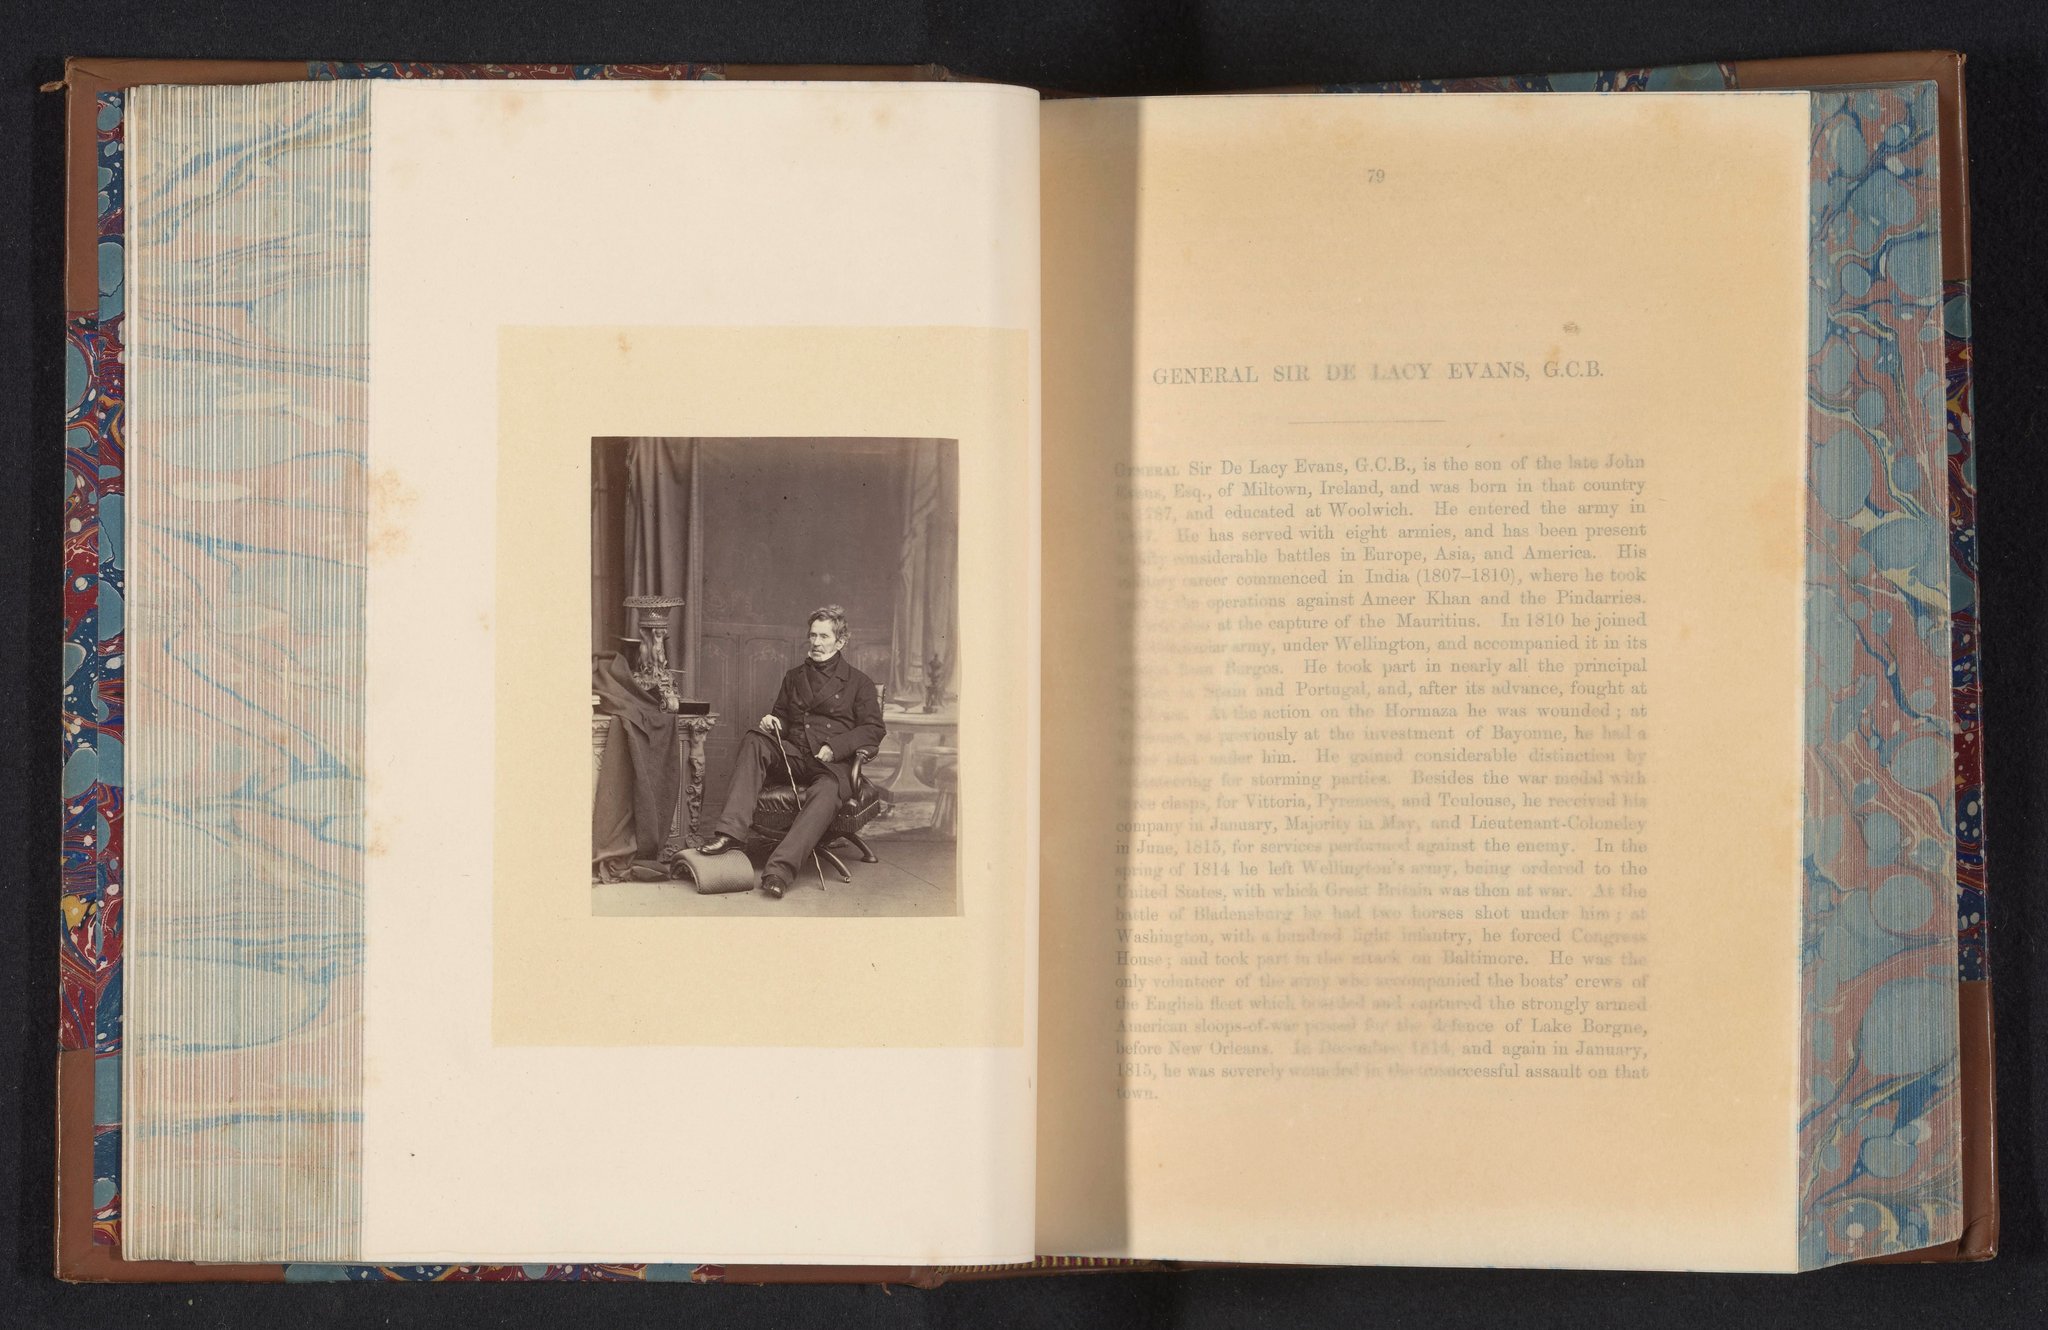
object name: page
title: Portret van Sir George de Lacy Evans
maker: ernest edwards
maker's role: fotograaf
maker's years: 1837-1903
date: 1853-1867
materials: photographic support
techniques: albumen print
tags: studio requisites ~ photographer, commander-in-chief, general, marshal